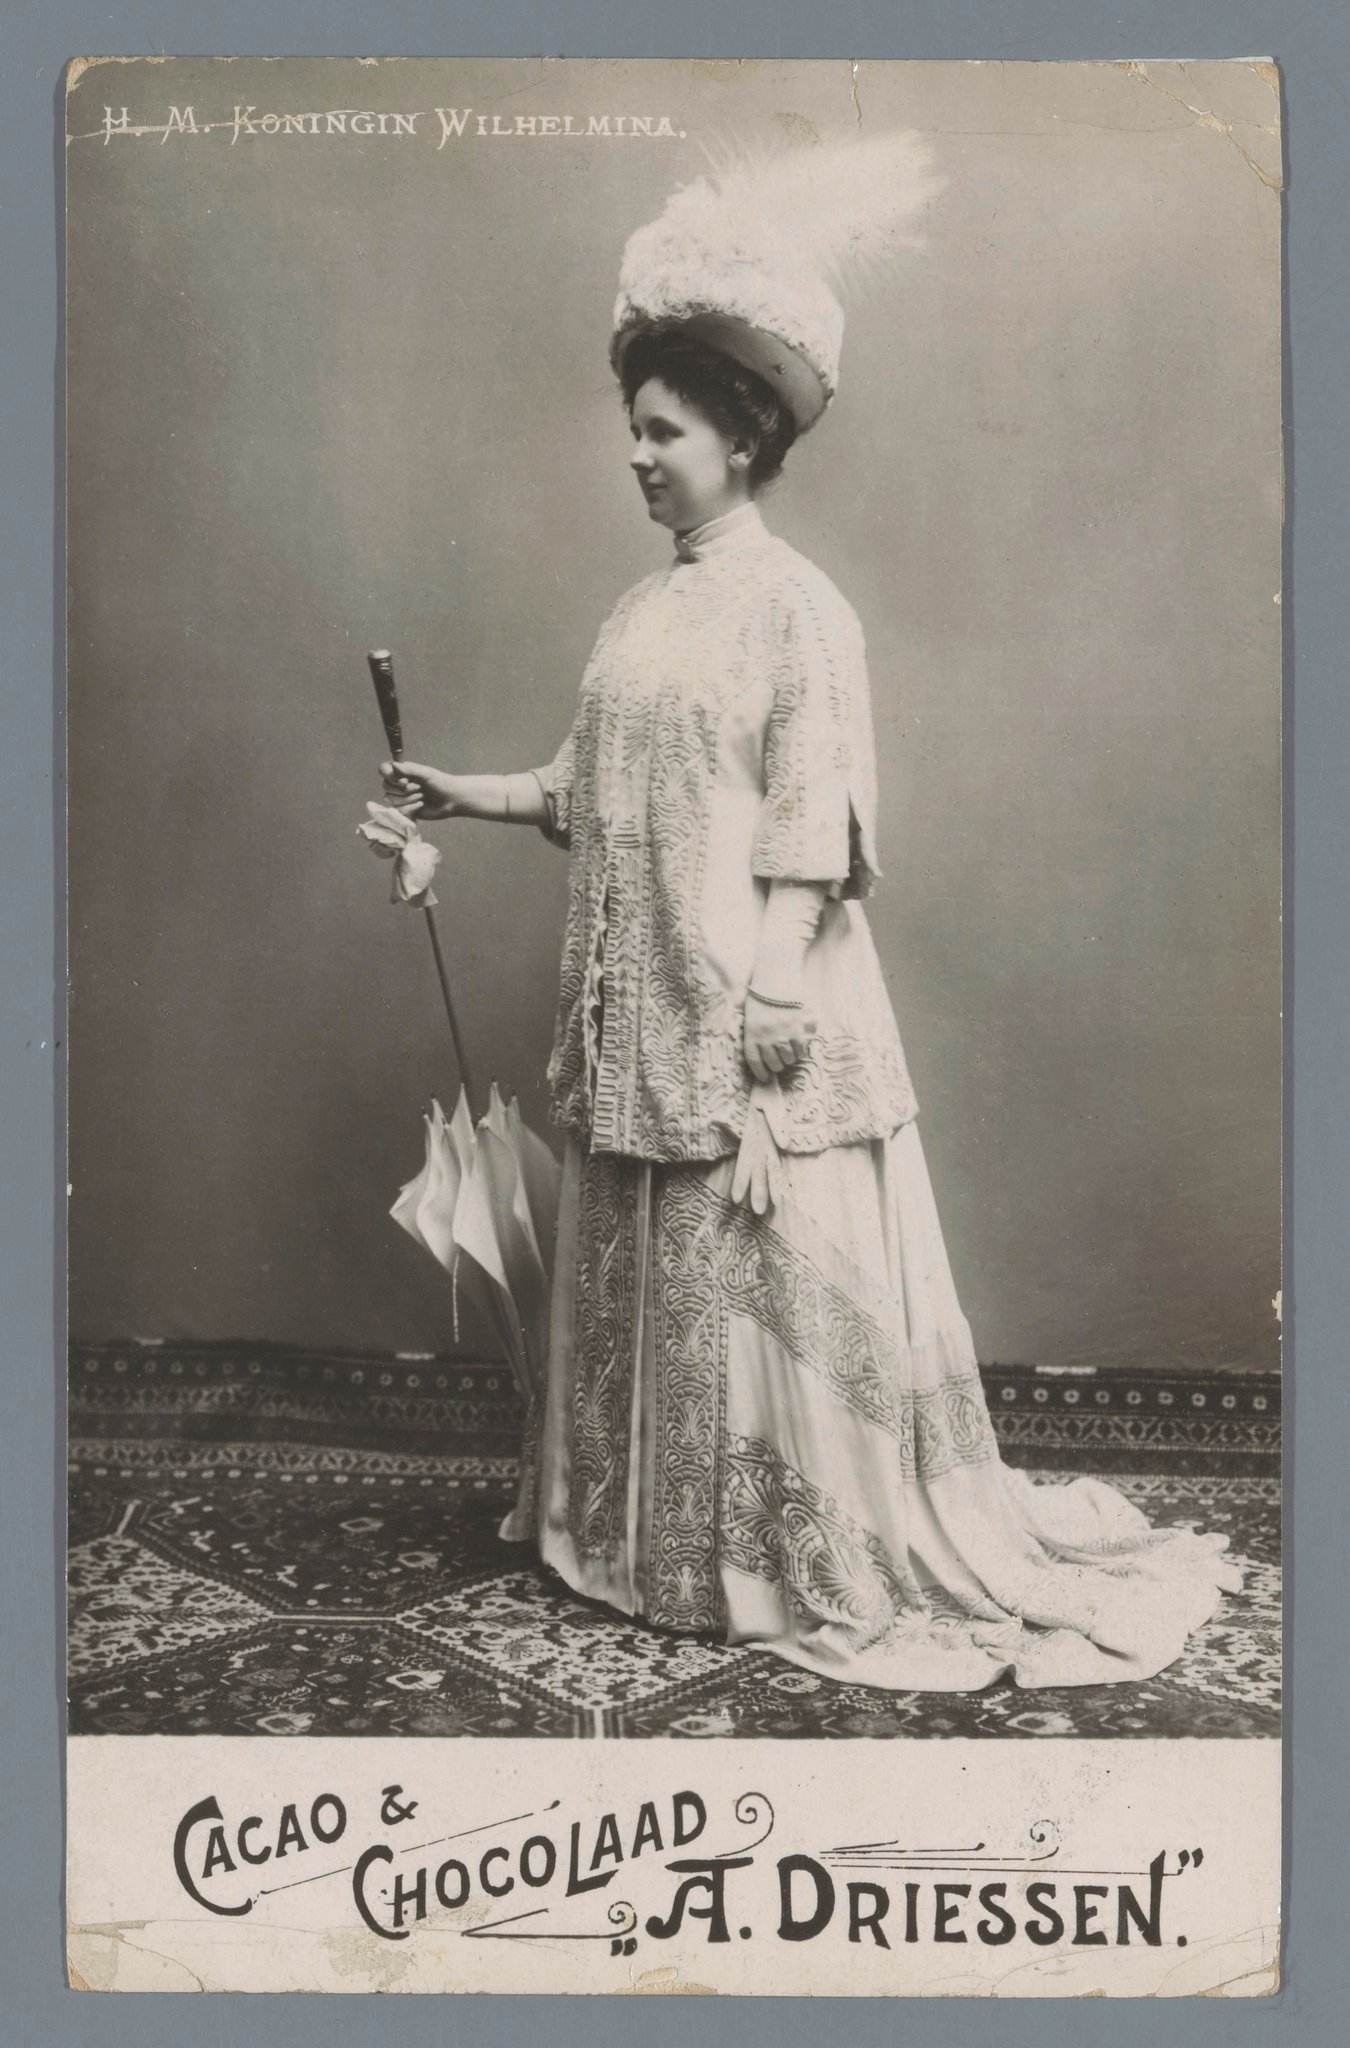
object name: photograph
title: H.M. Koningin Wilhelmina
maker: Anonymous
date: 1901-1910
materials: photographic support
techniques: gelatin silver print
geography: netherlands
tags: the hague, print maker, wilhelmina of the netherlands, historical persons, queen, head-gear: cap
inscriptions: inscription: ‘CACAO &/ CHOCOLAAD/ "A. DRIESSEN".’